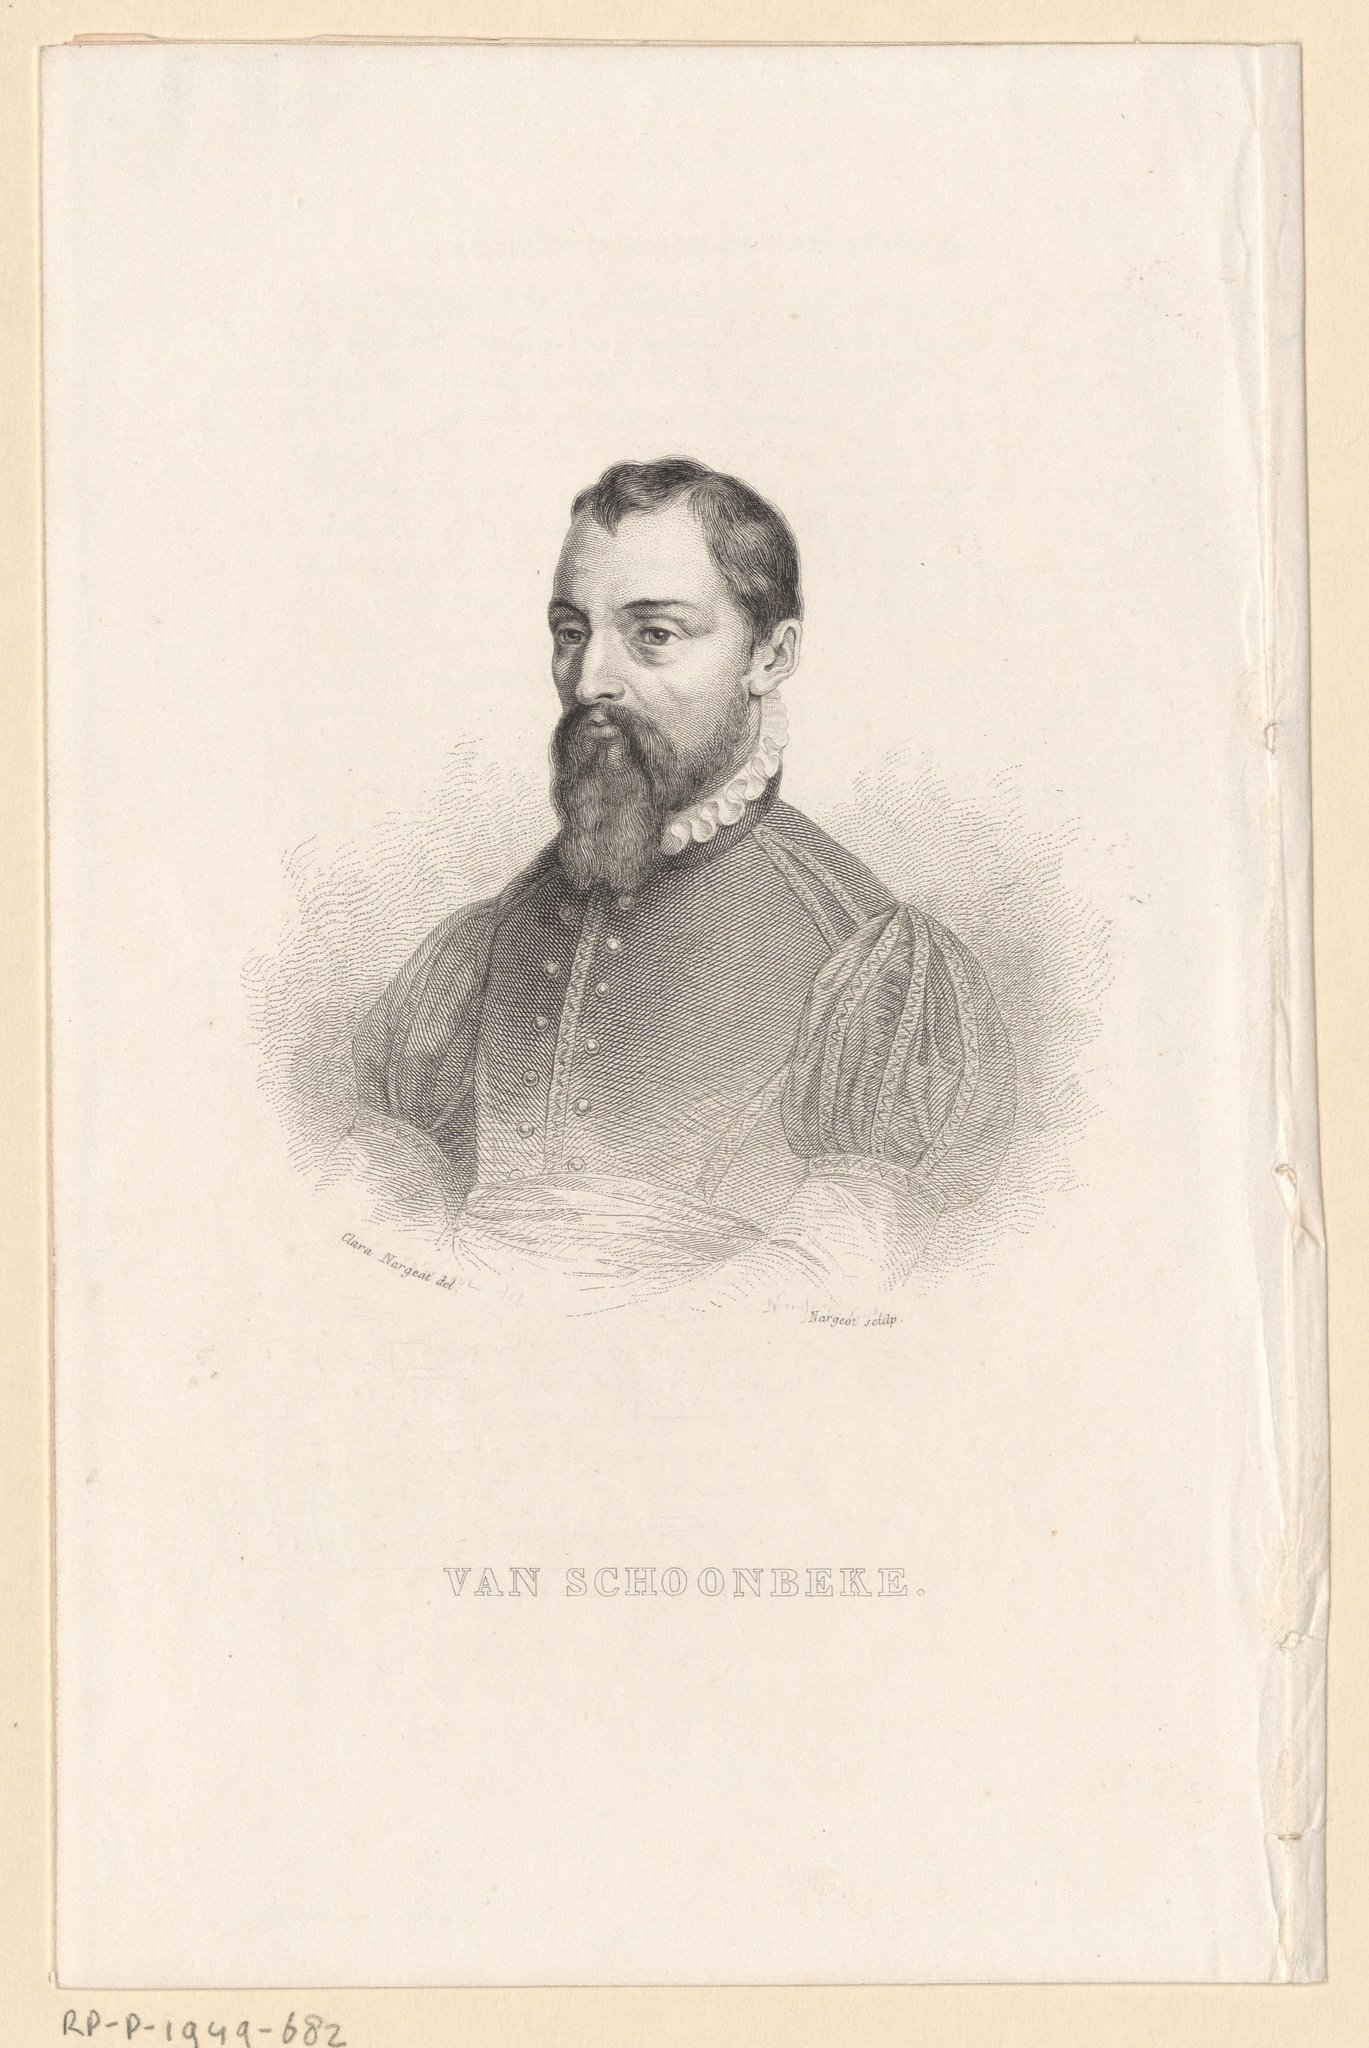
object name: print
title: Portret van Gilbert van Schoonbeke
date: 1841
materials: paper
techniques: engraving, etching, letterpress printing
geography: antwerp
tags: gilbert van schoonbeke, historical persons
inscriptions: collector's mark: Lugt 2228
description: Prent uit: Société Montyon et Franklin. Portraits et histoire des hommes utiles bienfaiteurs et bienfaitrices. Parijs: Henri Lebrun, 1841, dl. 9.